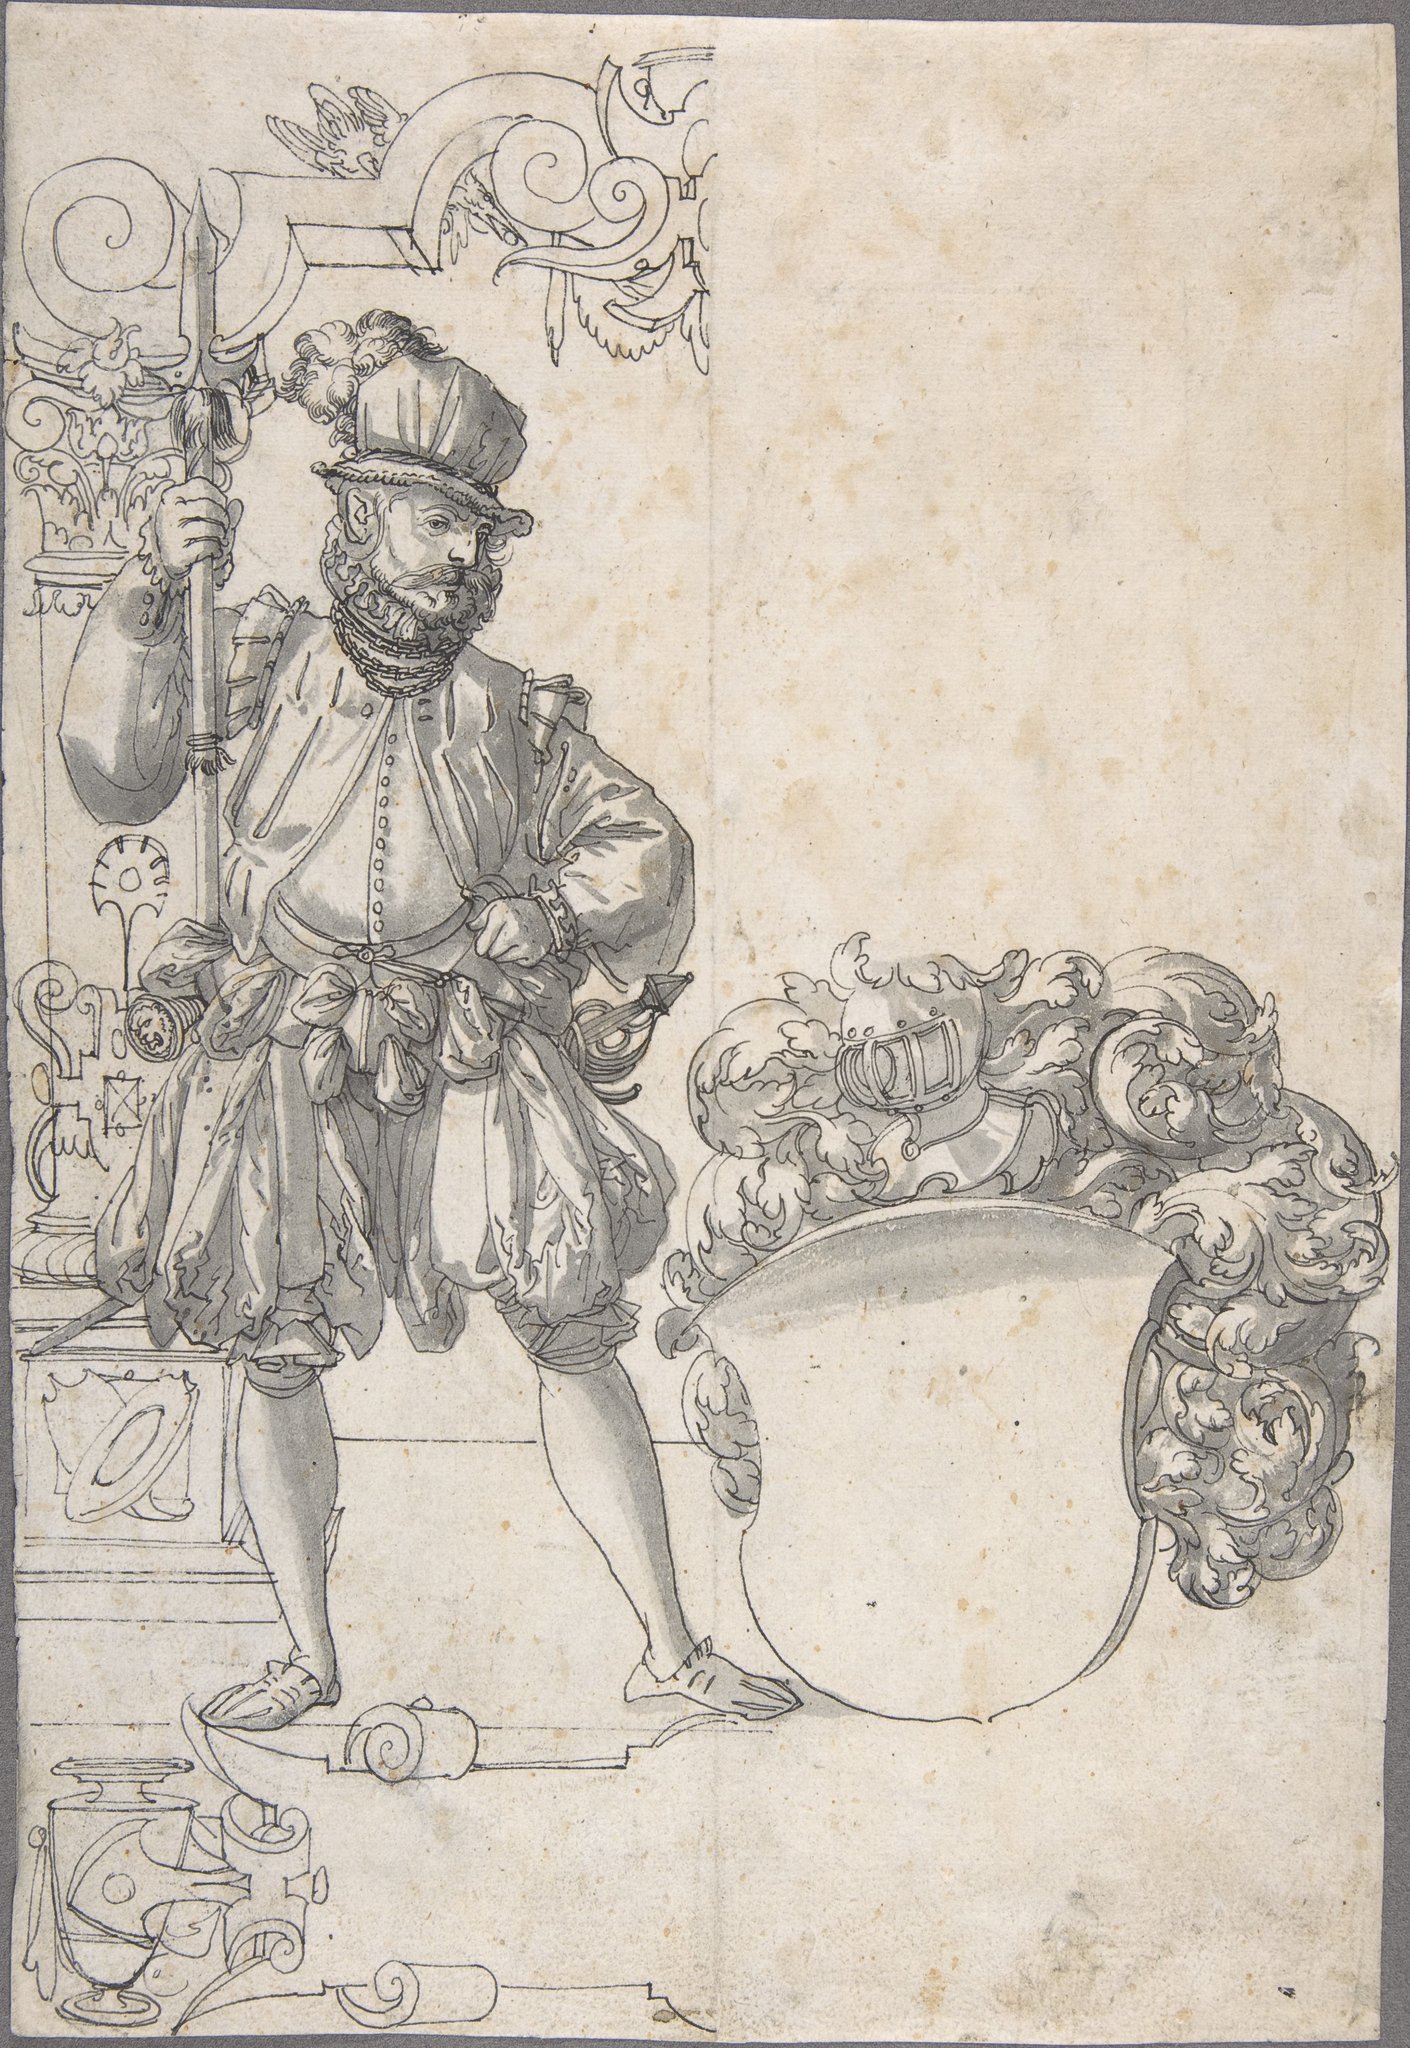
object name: collection ornament architecture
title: Design for Stained Glass: A Halbardier by an Unfinished Coat of Arms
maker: hans jakob plepp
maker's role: artist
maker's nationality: swiss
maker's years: 1557-1597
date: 1570-1580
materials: ink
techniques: pen, wash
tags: men,coat of arms